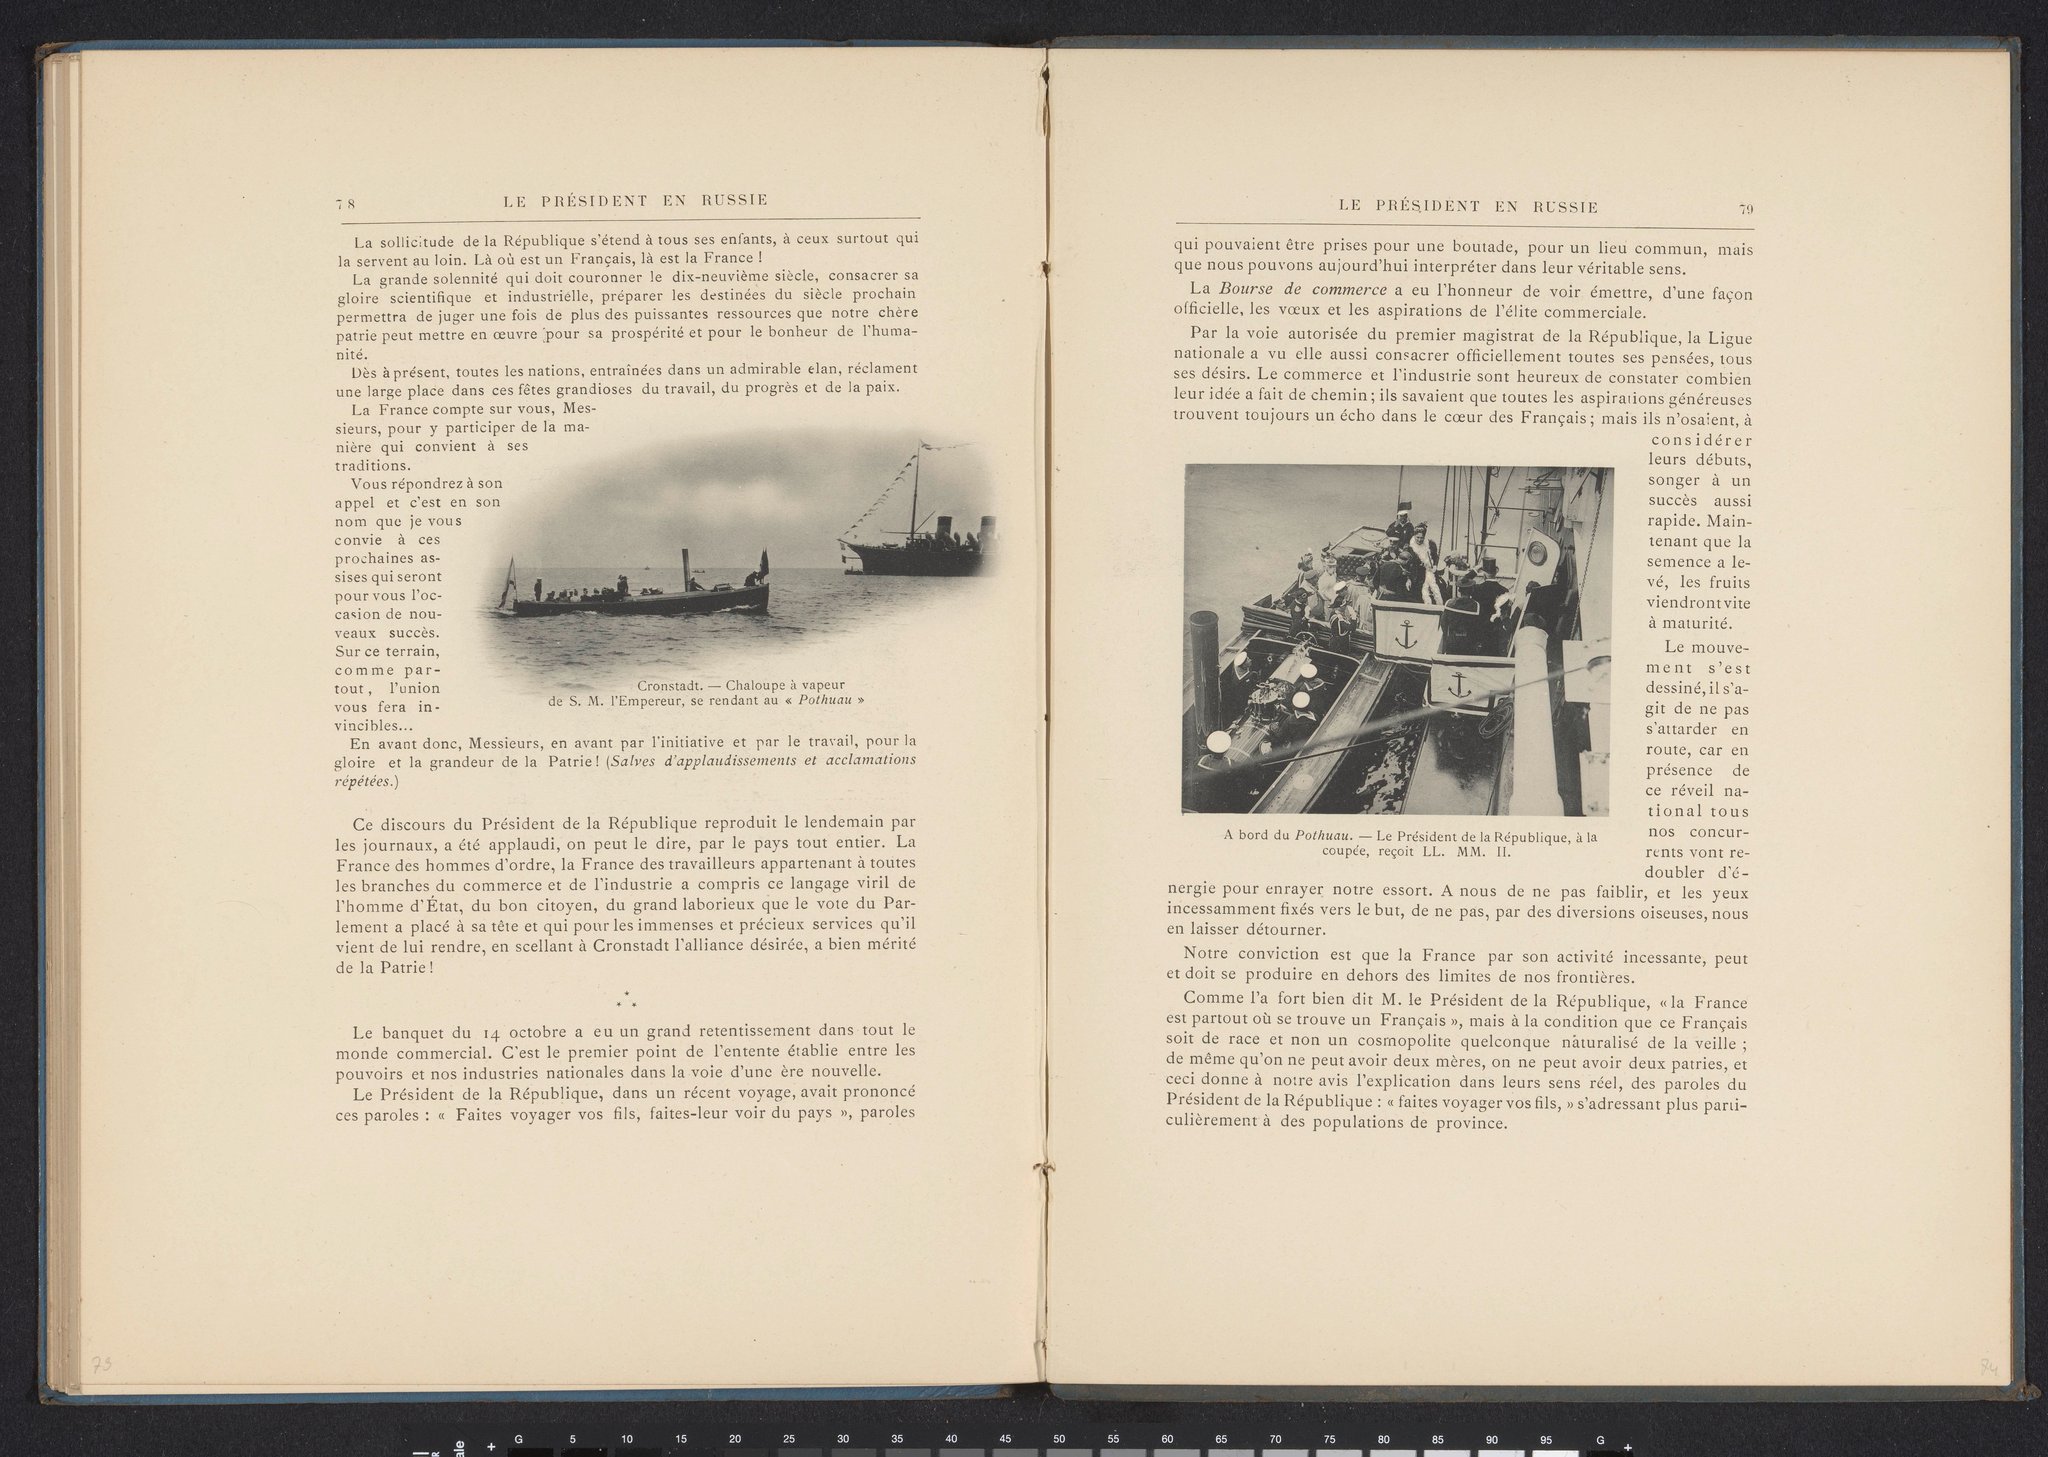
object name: photomechanical print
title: Stoomboot van tsaar Nicolaas II van Rusland vaart naar de kruiser Pothuau te Kronstadt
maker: Anonymous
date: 1897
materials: paper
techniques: photograph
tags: ships (in general), steamship, motorship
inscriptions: inscription: ‘Cronstadt. (...) < Pothuau >’